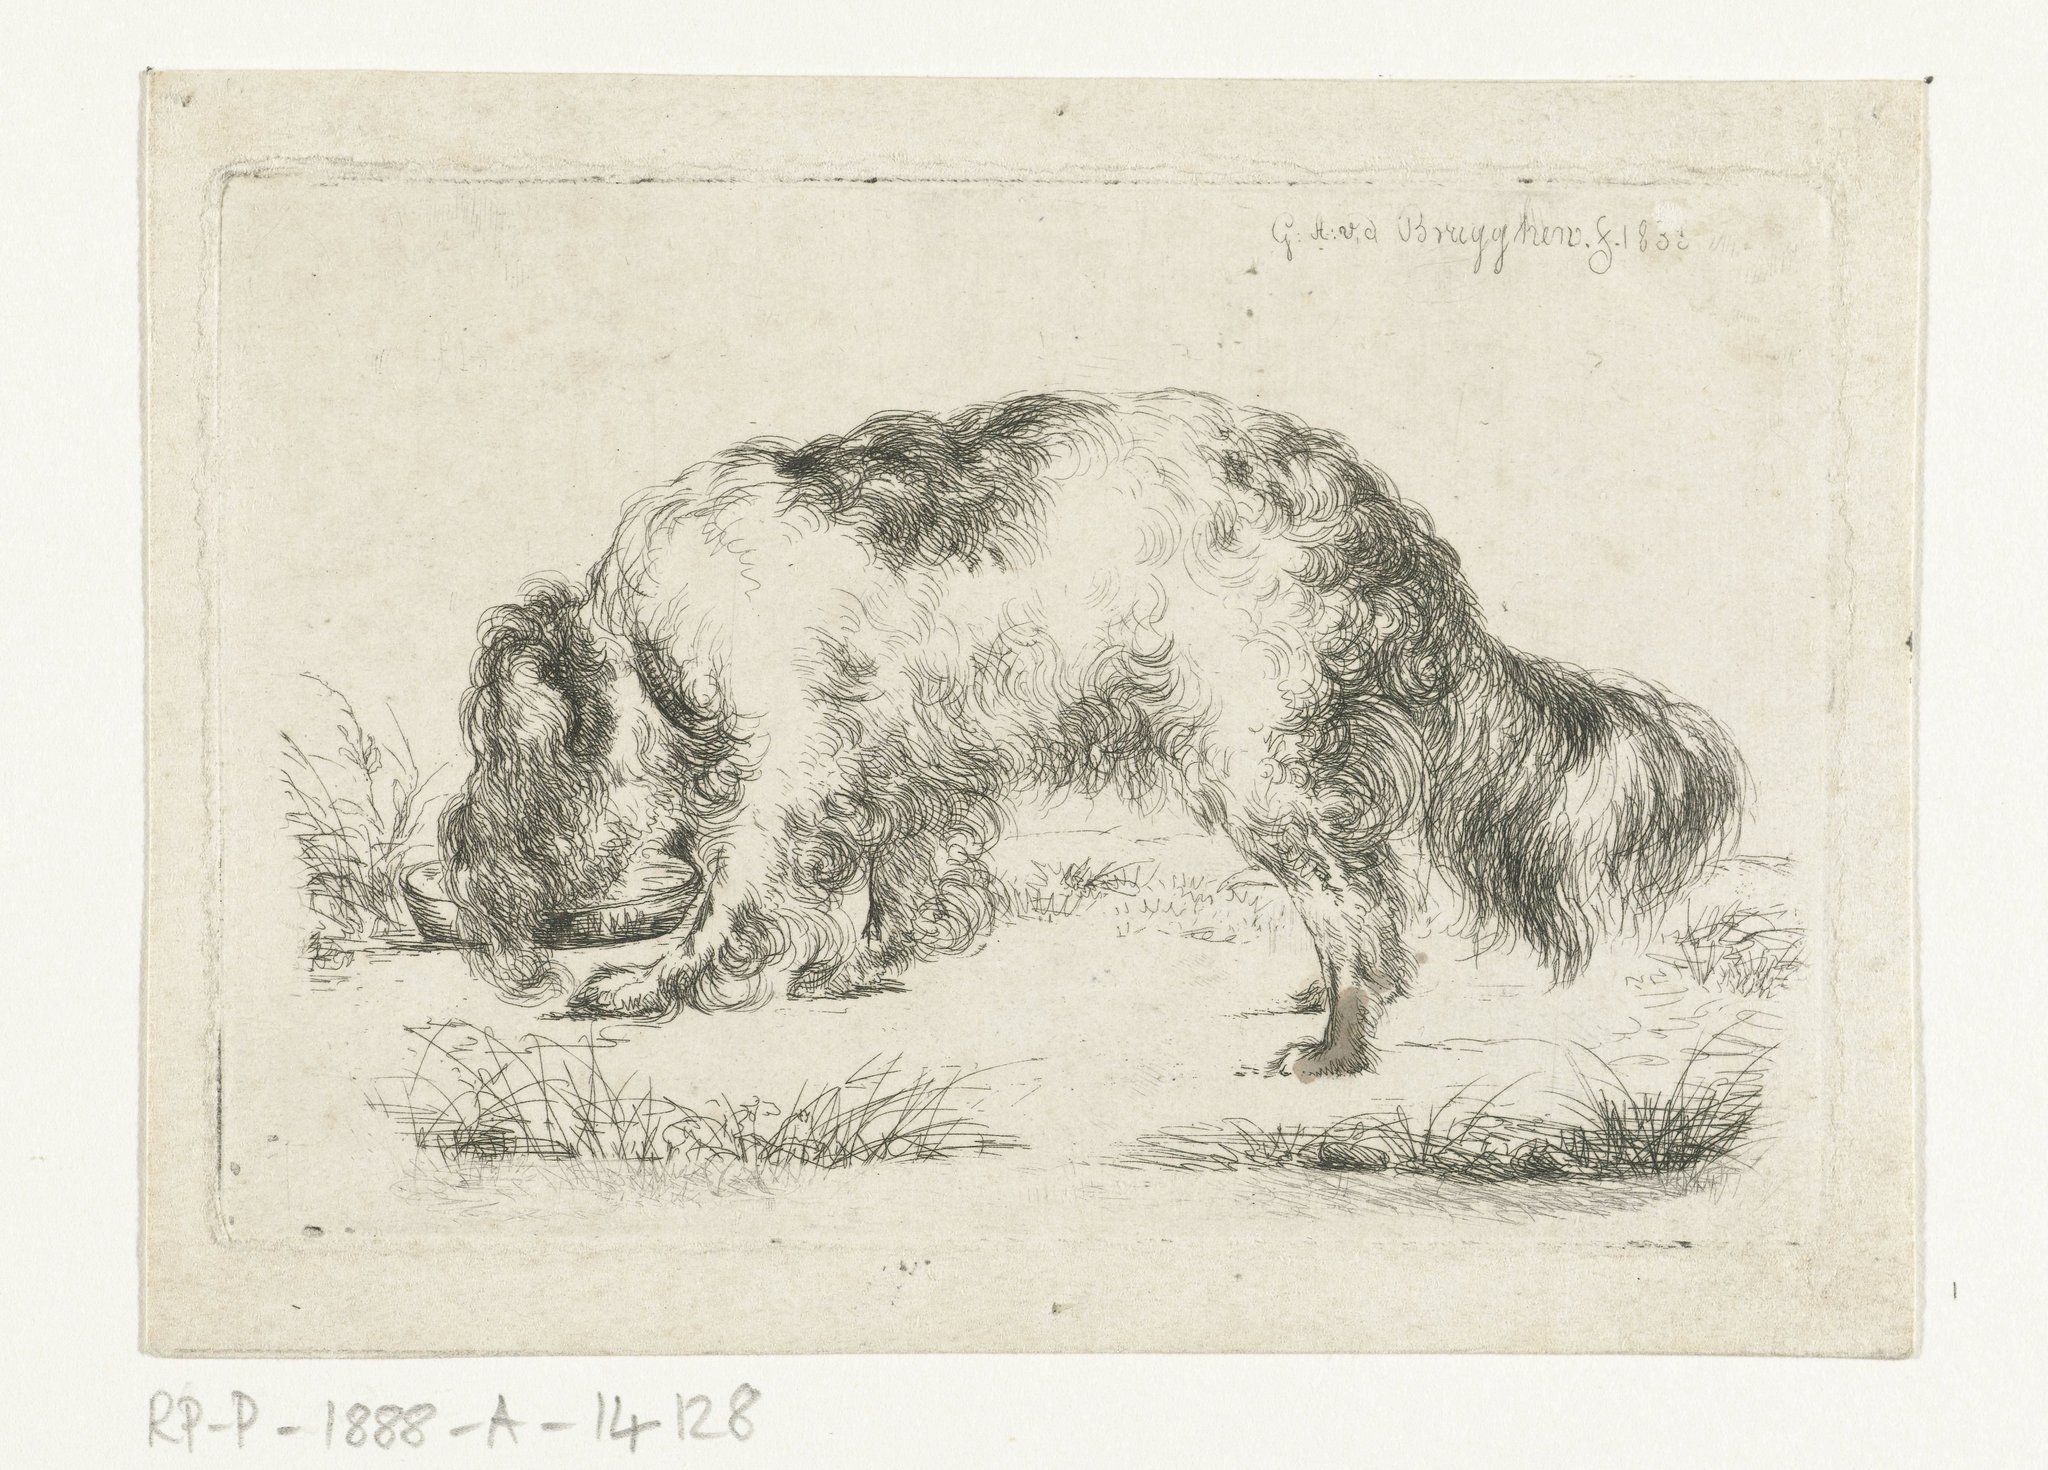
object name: print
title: Drinkende hond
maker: guillaume anne van der brugghen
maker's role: draughtsman, print maker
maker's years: 1812-1891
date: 1832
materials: paper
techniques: etching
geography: netherlands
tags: dog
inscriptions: collector's mark: Lugt 2228